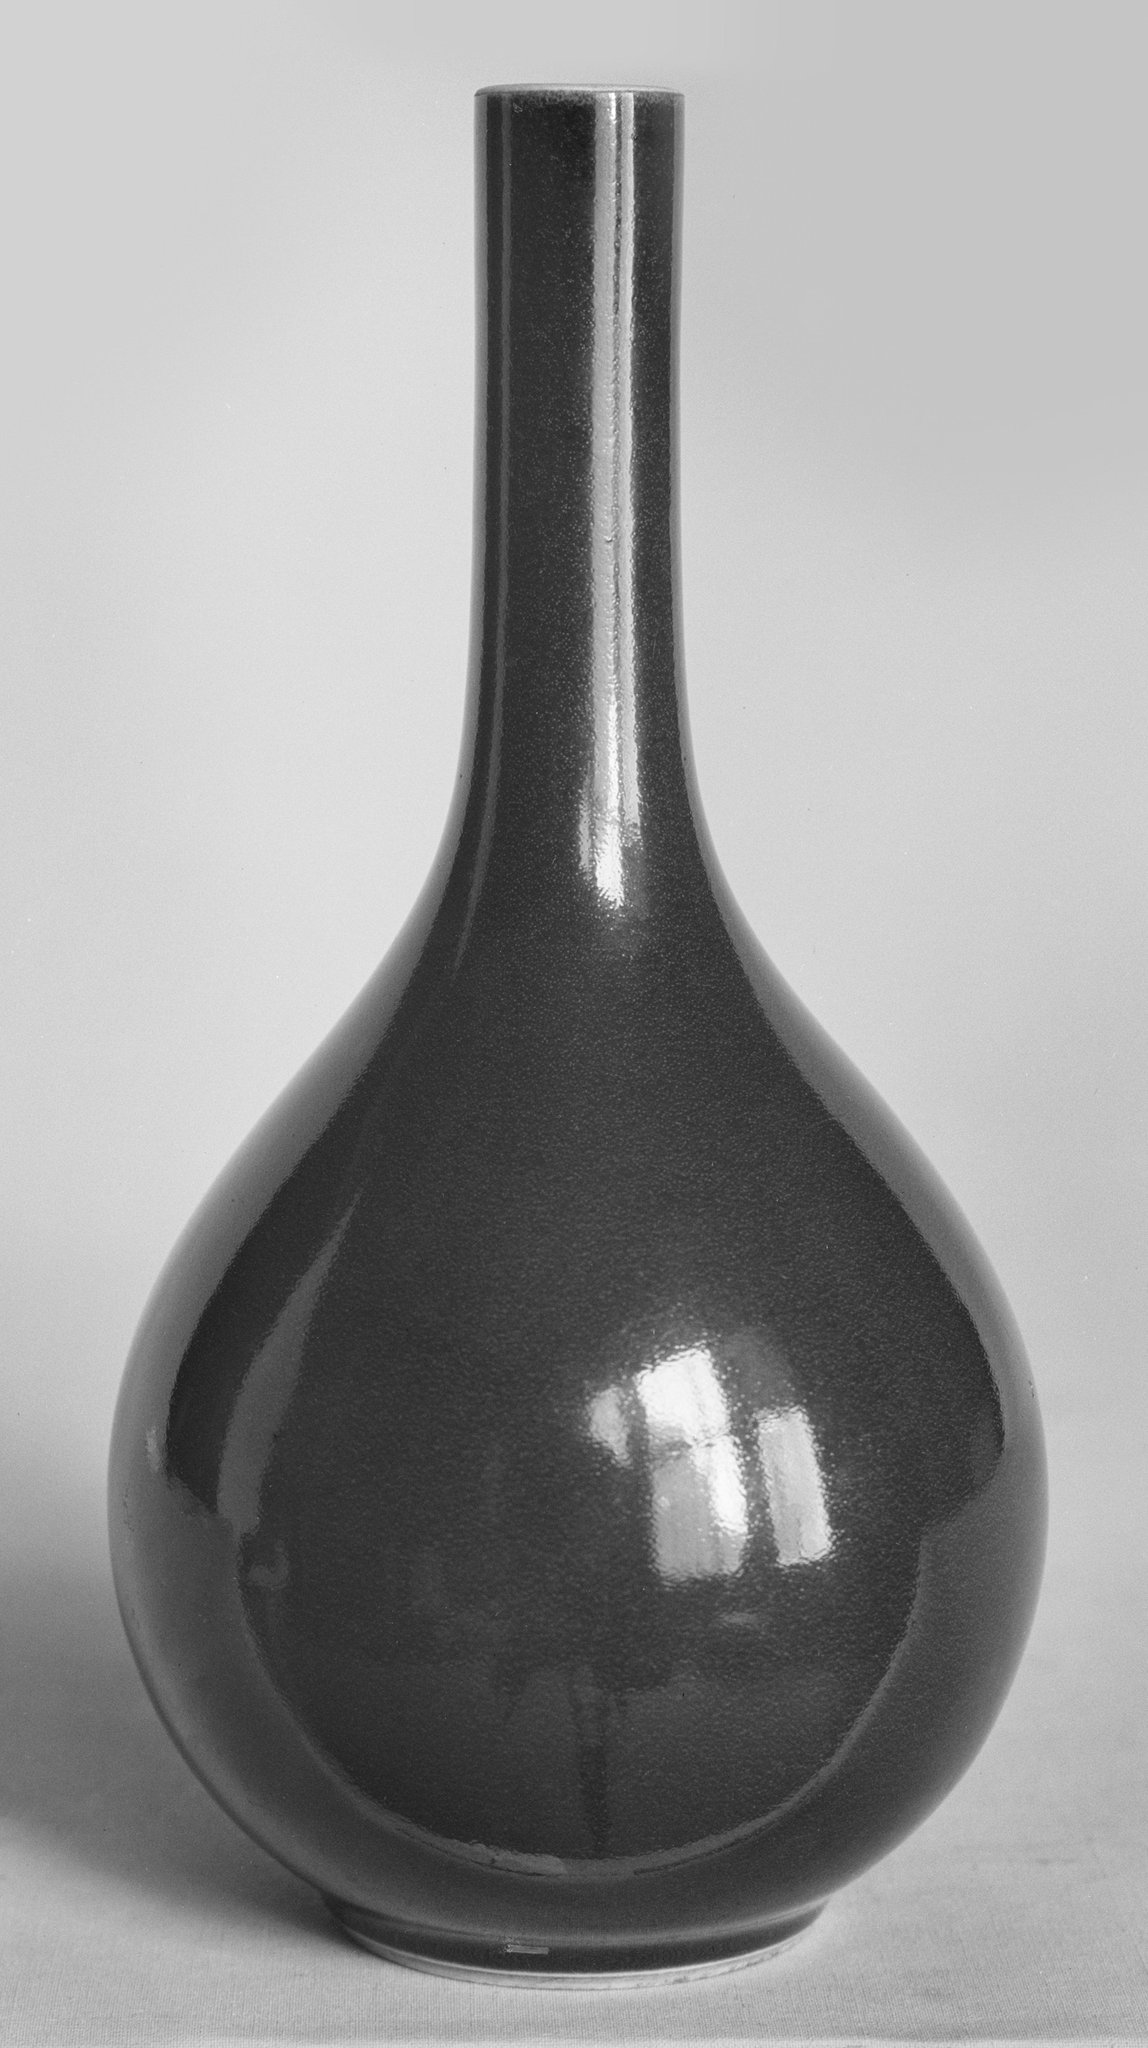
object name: bottle vase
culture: chinese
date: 1701-1800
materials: copper, glaze, porcelain